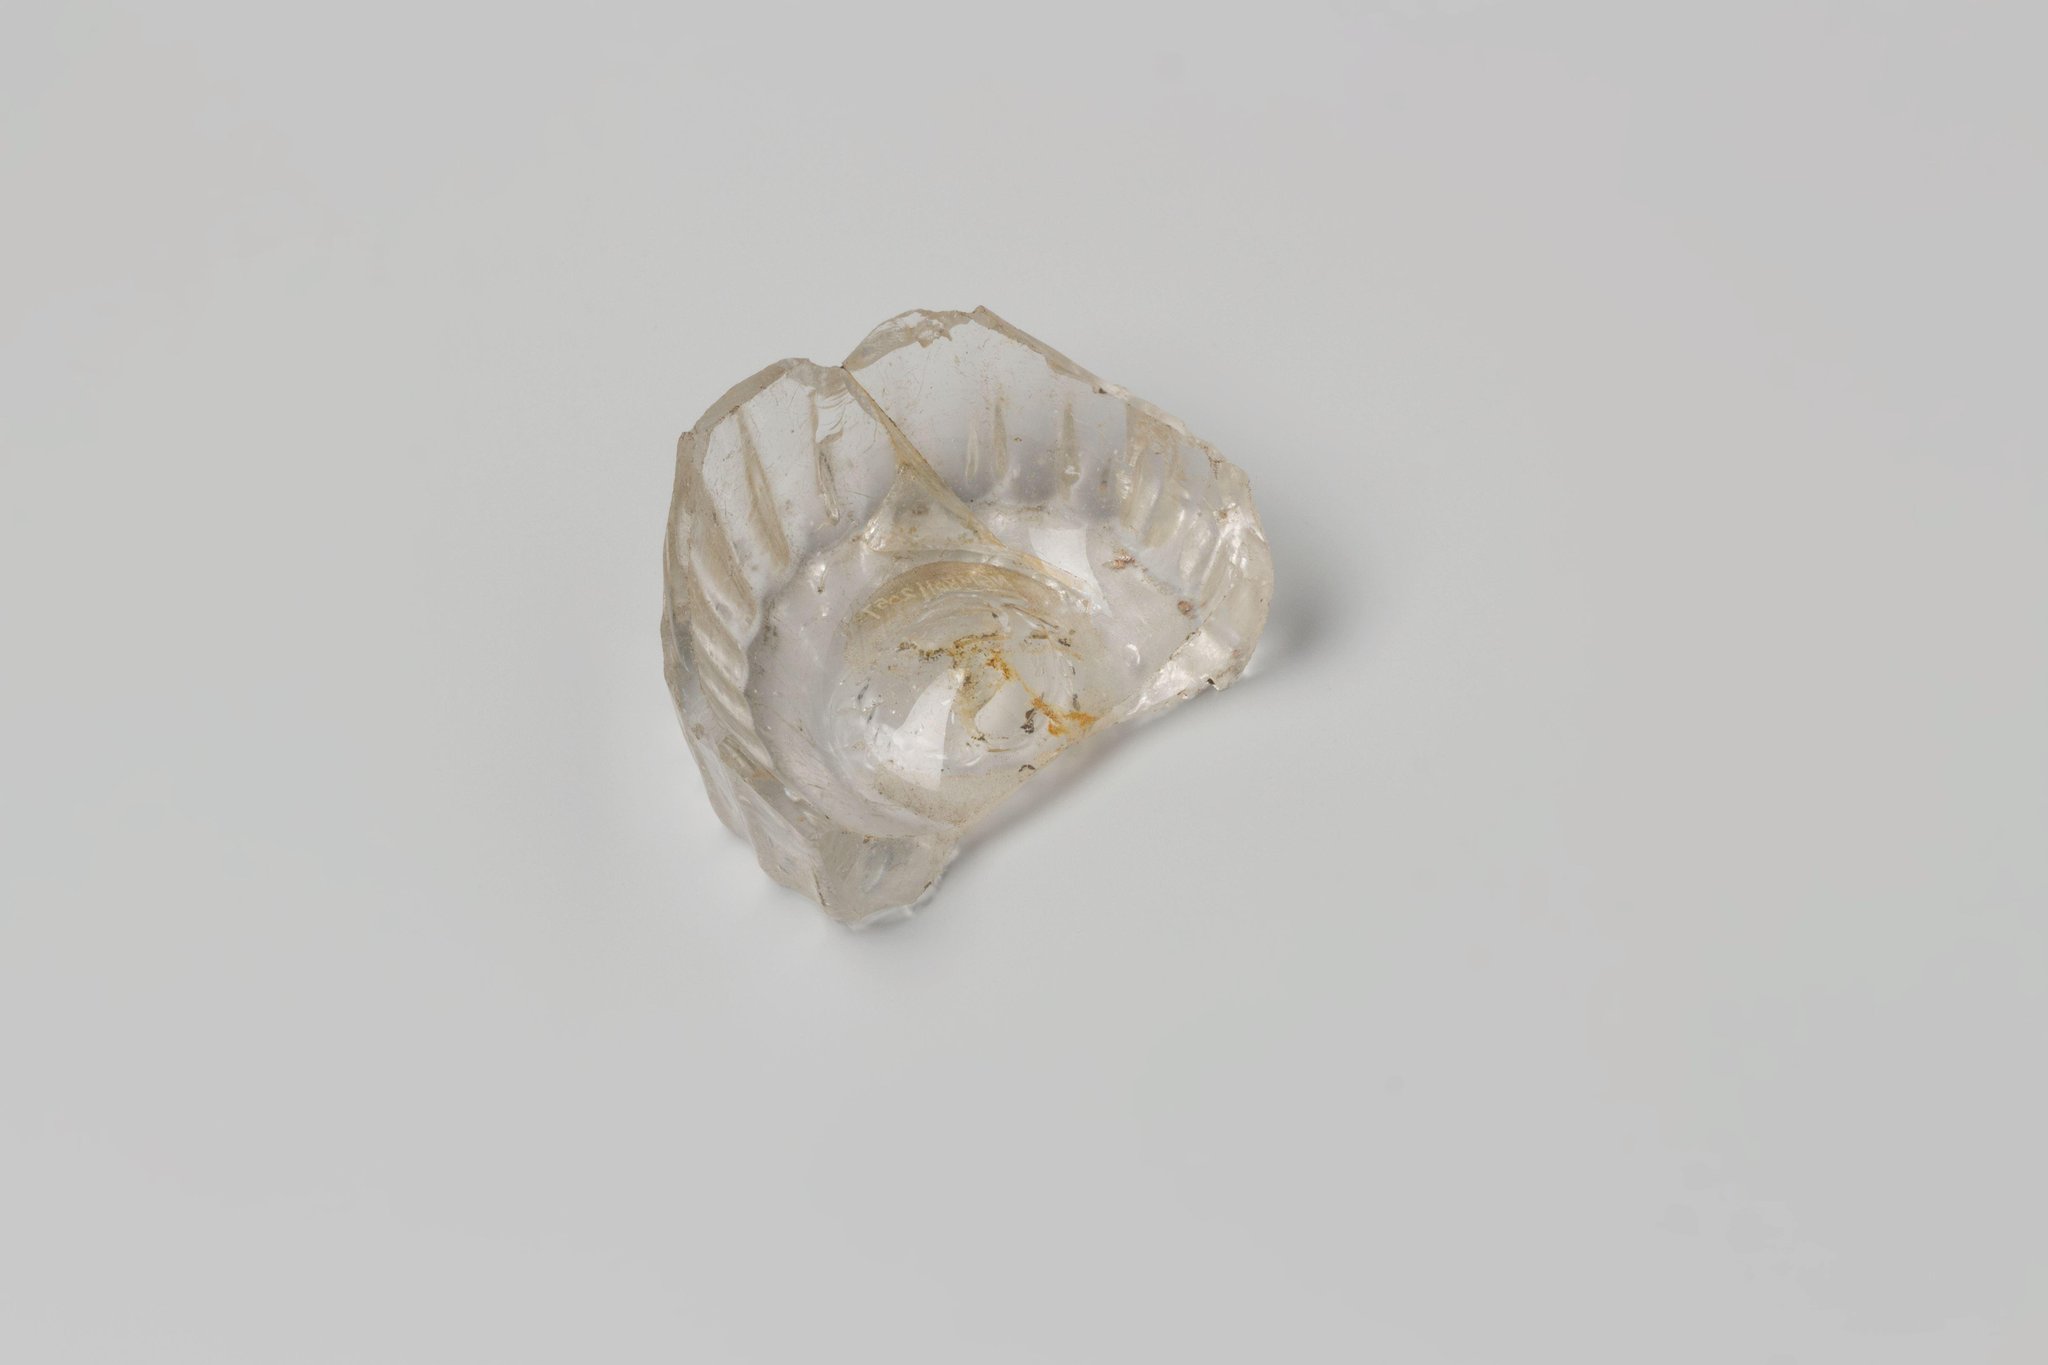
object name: tumbler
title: Fragment tuimelaar uit het wrak van de Oost-Indiëvaarder Hollandia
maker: Anonymous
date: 1700-1743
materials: glass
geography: netherlands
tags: verenigde oostindische compagnie, hollandia (schip), annet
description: Base, fragm, circular, domed kick-up with pontil mark, everted sides, ribbed exterior. Tumbler.